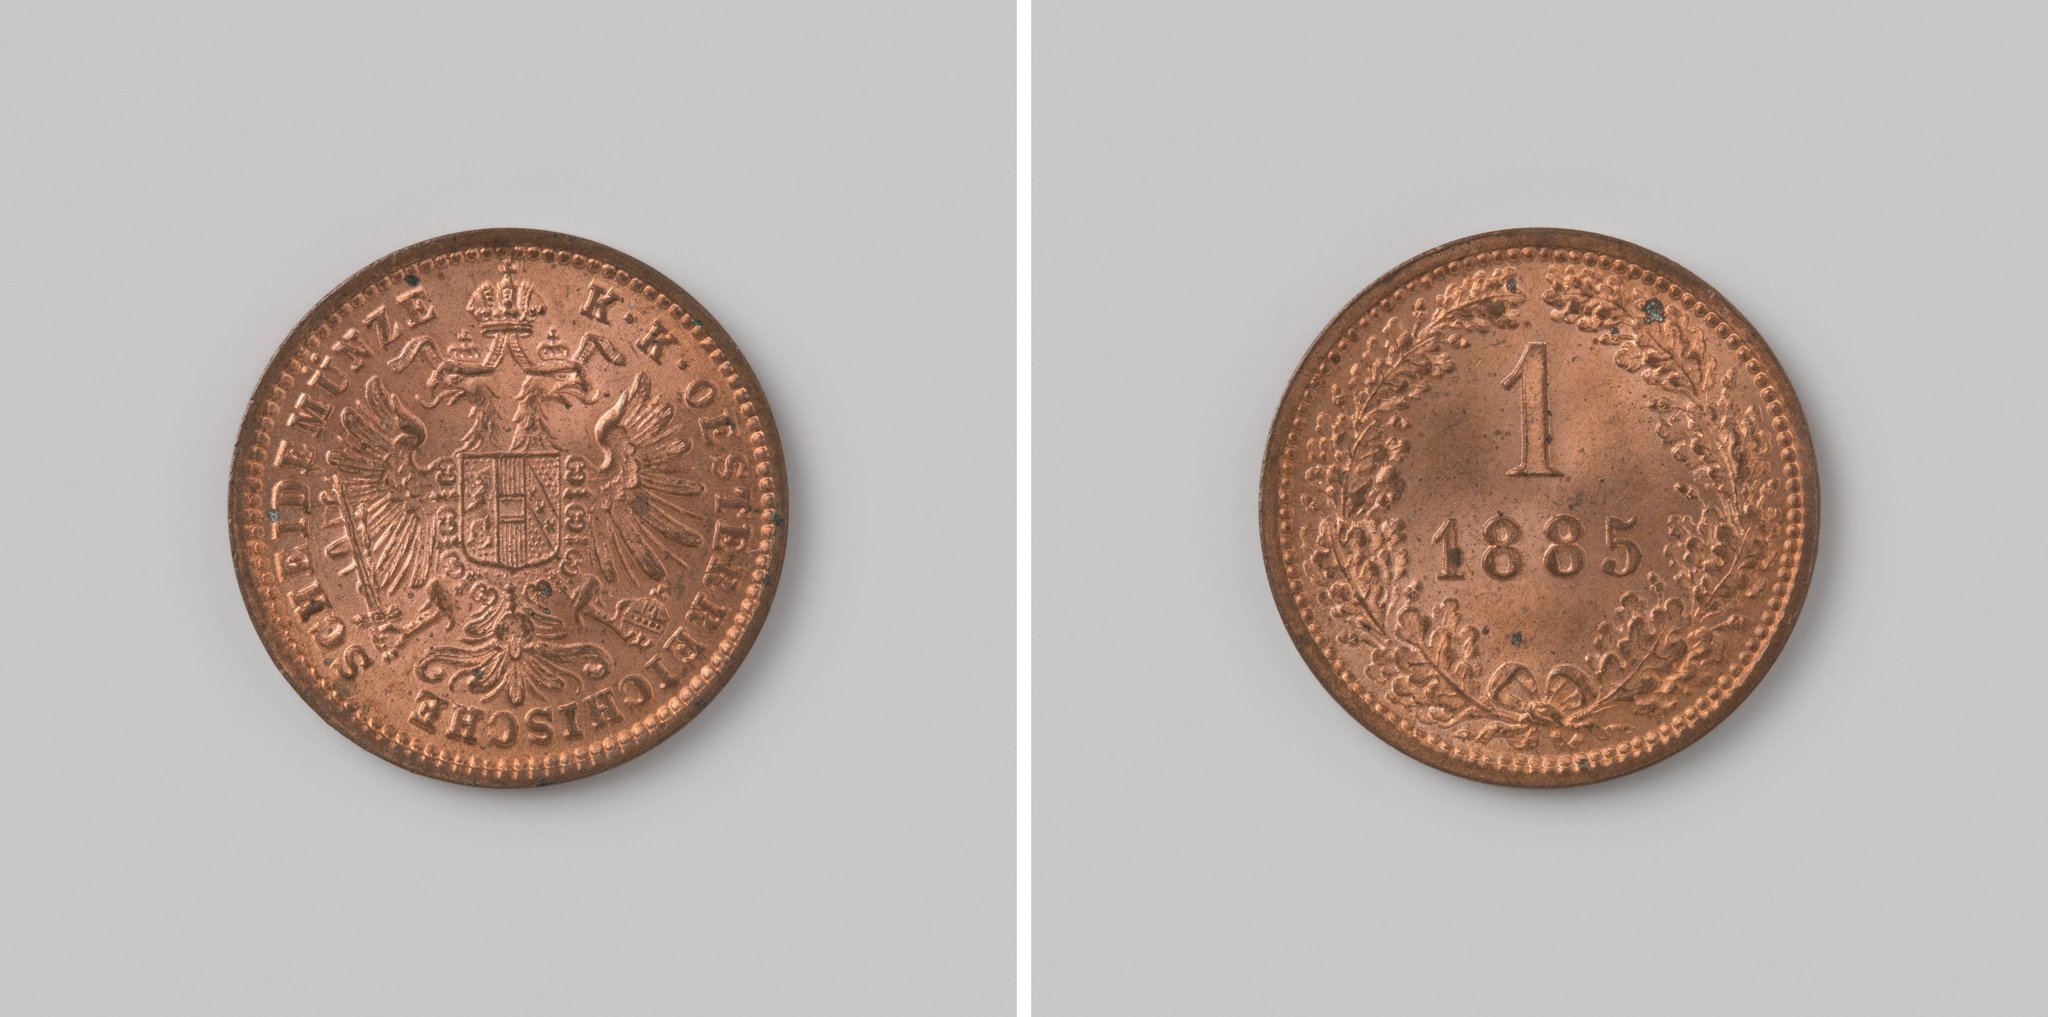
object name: coin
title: Keizerrijk Oostenrijk, Franz Joseph,kreuzer,1885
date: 1885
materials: copper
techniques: striking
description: Koperen munt. Voorzijde: wapen van Oostenrijk. Keerzijde: binnen twee samengebonden takken waarde-aanduiding, waaronder jaartal. Gladde rand.